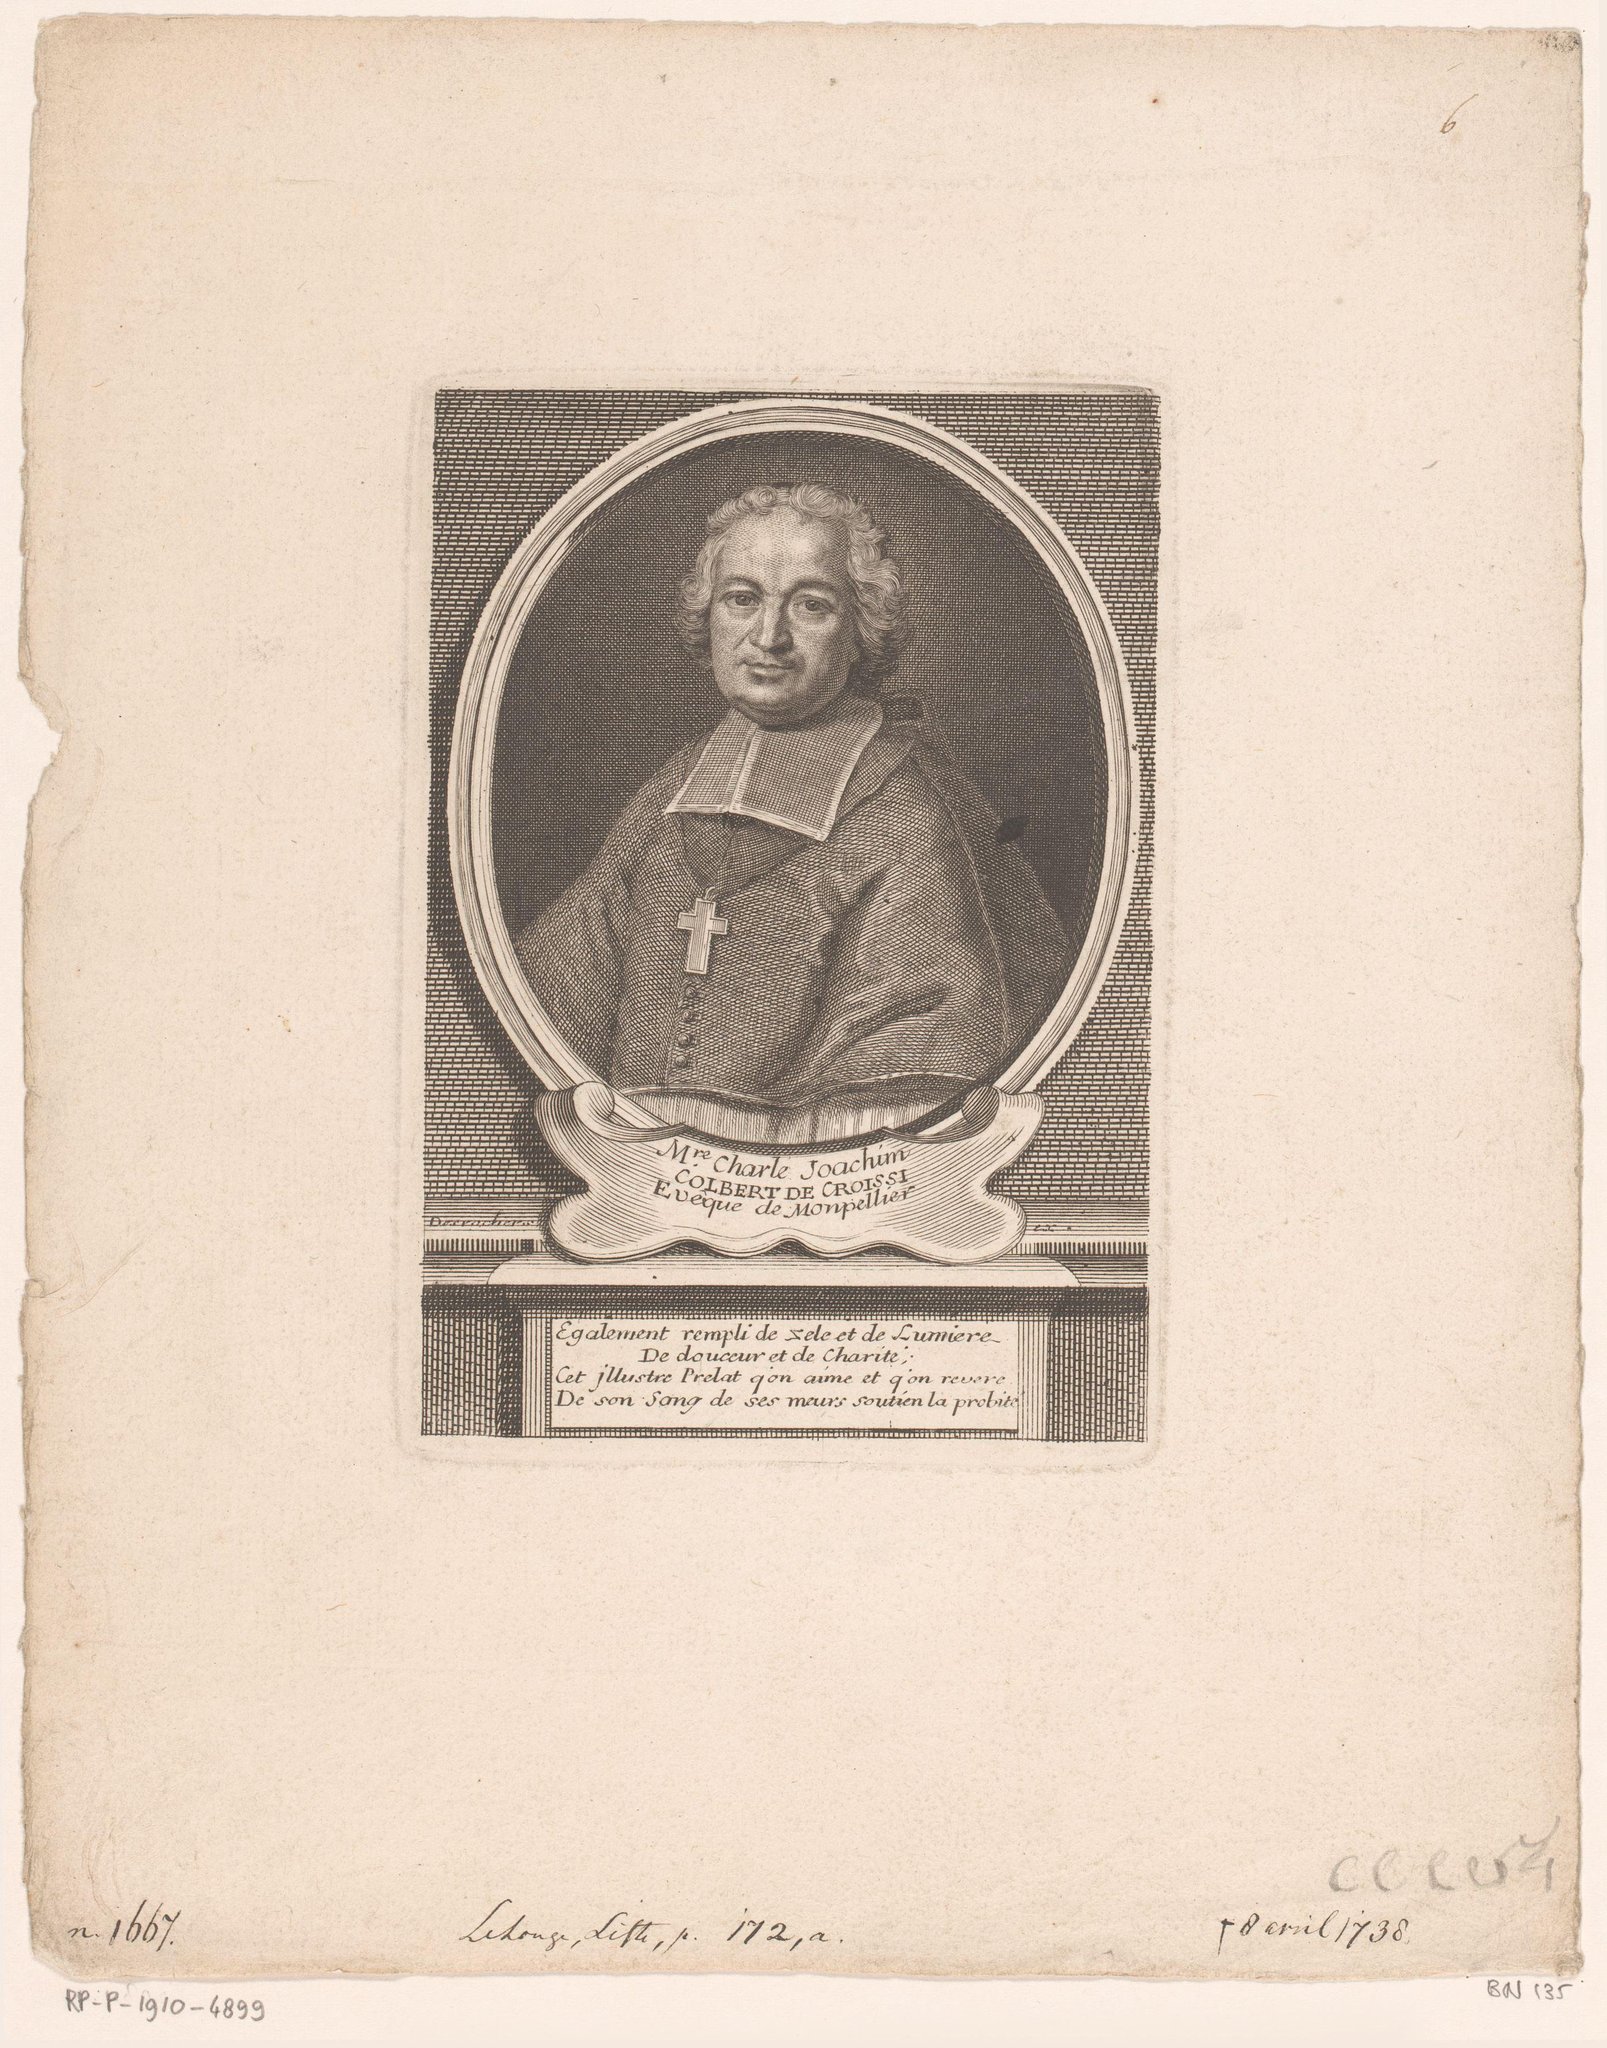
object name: print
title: Portret van Charles-Joachim Colbert de Croissy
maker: étienne desrochers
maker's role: print maker, publisher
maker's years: 1668-1741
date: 1726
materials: paper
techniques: engraving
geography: paris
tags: paris, archbishop, bishop, etc. (roman catholic), historical persons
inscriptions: collector's mark: Lugt 2228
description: Behoort waarschijnlijk tot een serie portretten, grotendeels door Etienne Desrochers, getiteld: 'Recueil de portraits de personnes qui se sont distinguées tant dans les Armes que dans Belles-Lettres et les Arts, comme aussi la famille royale de France et autres cours étrangères'. De serie werd initieel uitgegeven door Desrochers en aangekondigd in 'Mercure' in mei 1726, p. 985. Echter was Desrochers reeds enkele jaren eerder begonnen met het uitgeven van de serie. Na de dood van Desrochers werd de serie voortgezet door Gilles Edme Petit. Een latere staat werd uitgegeven door Jean François Daumont in Parijs.